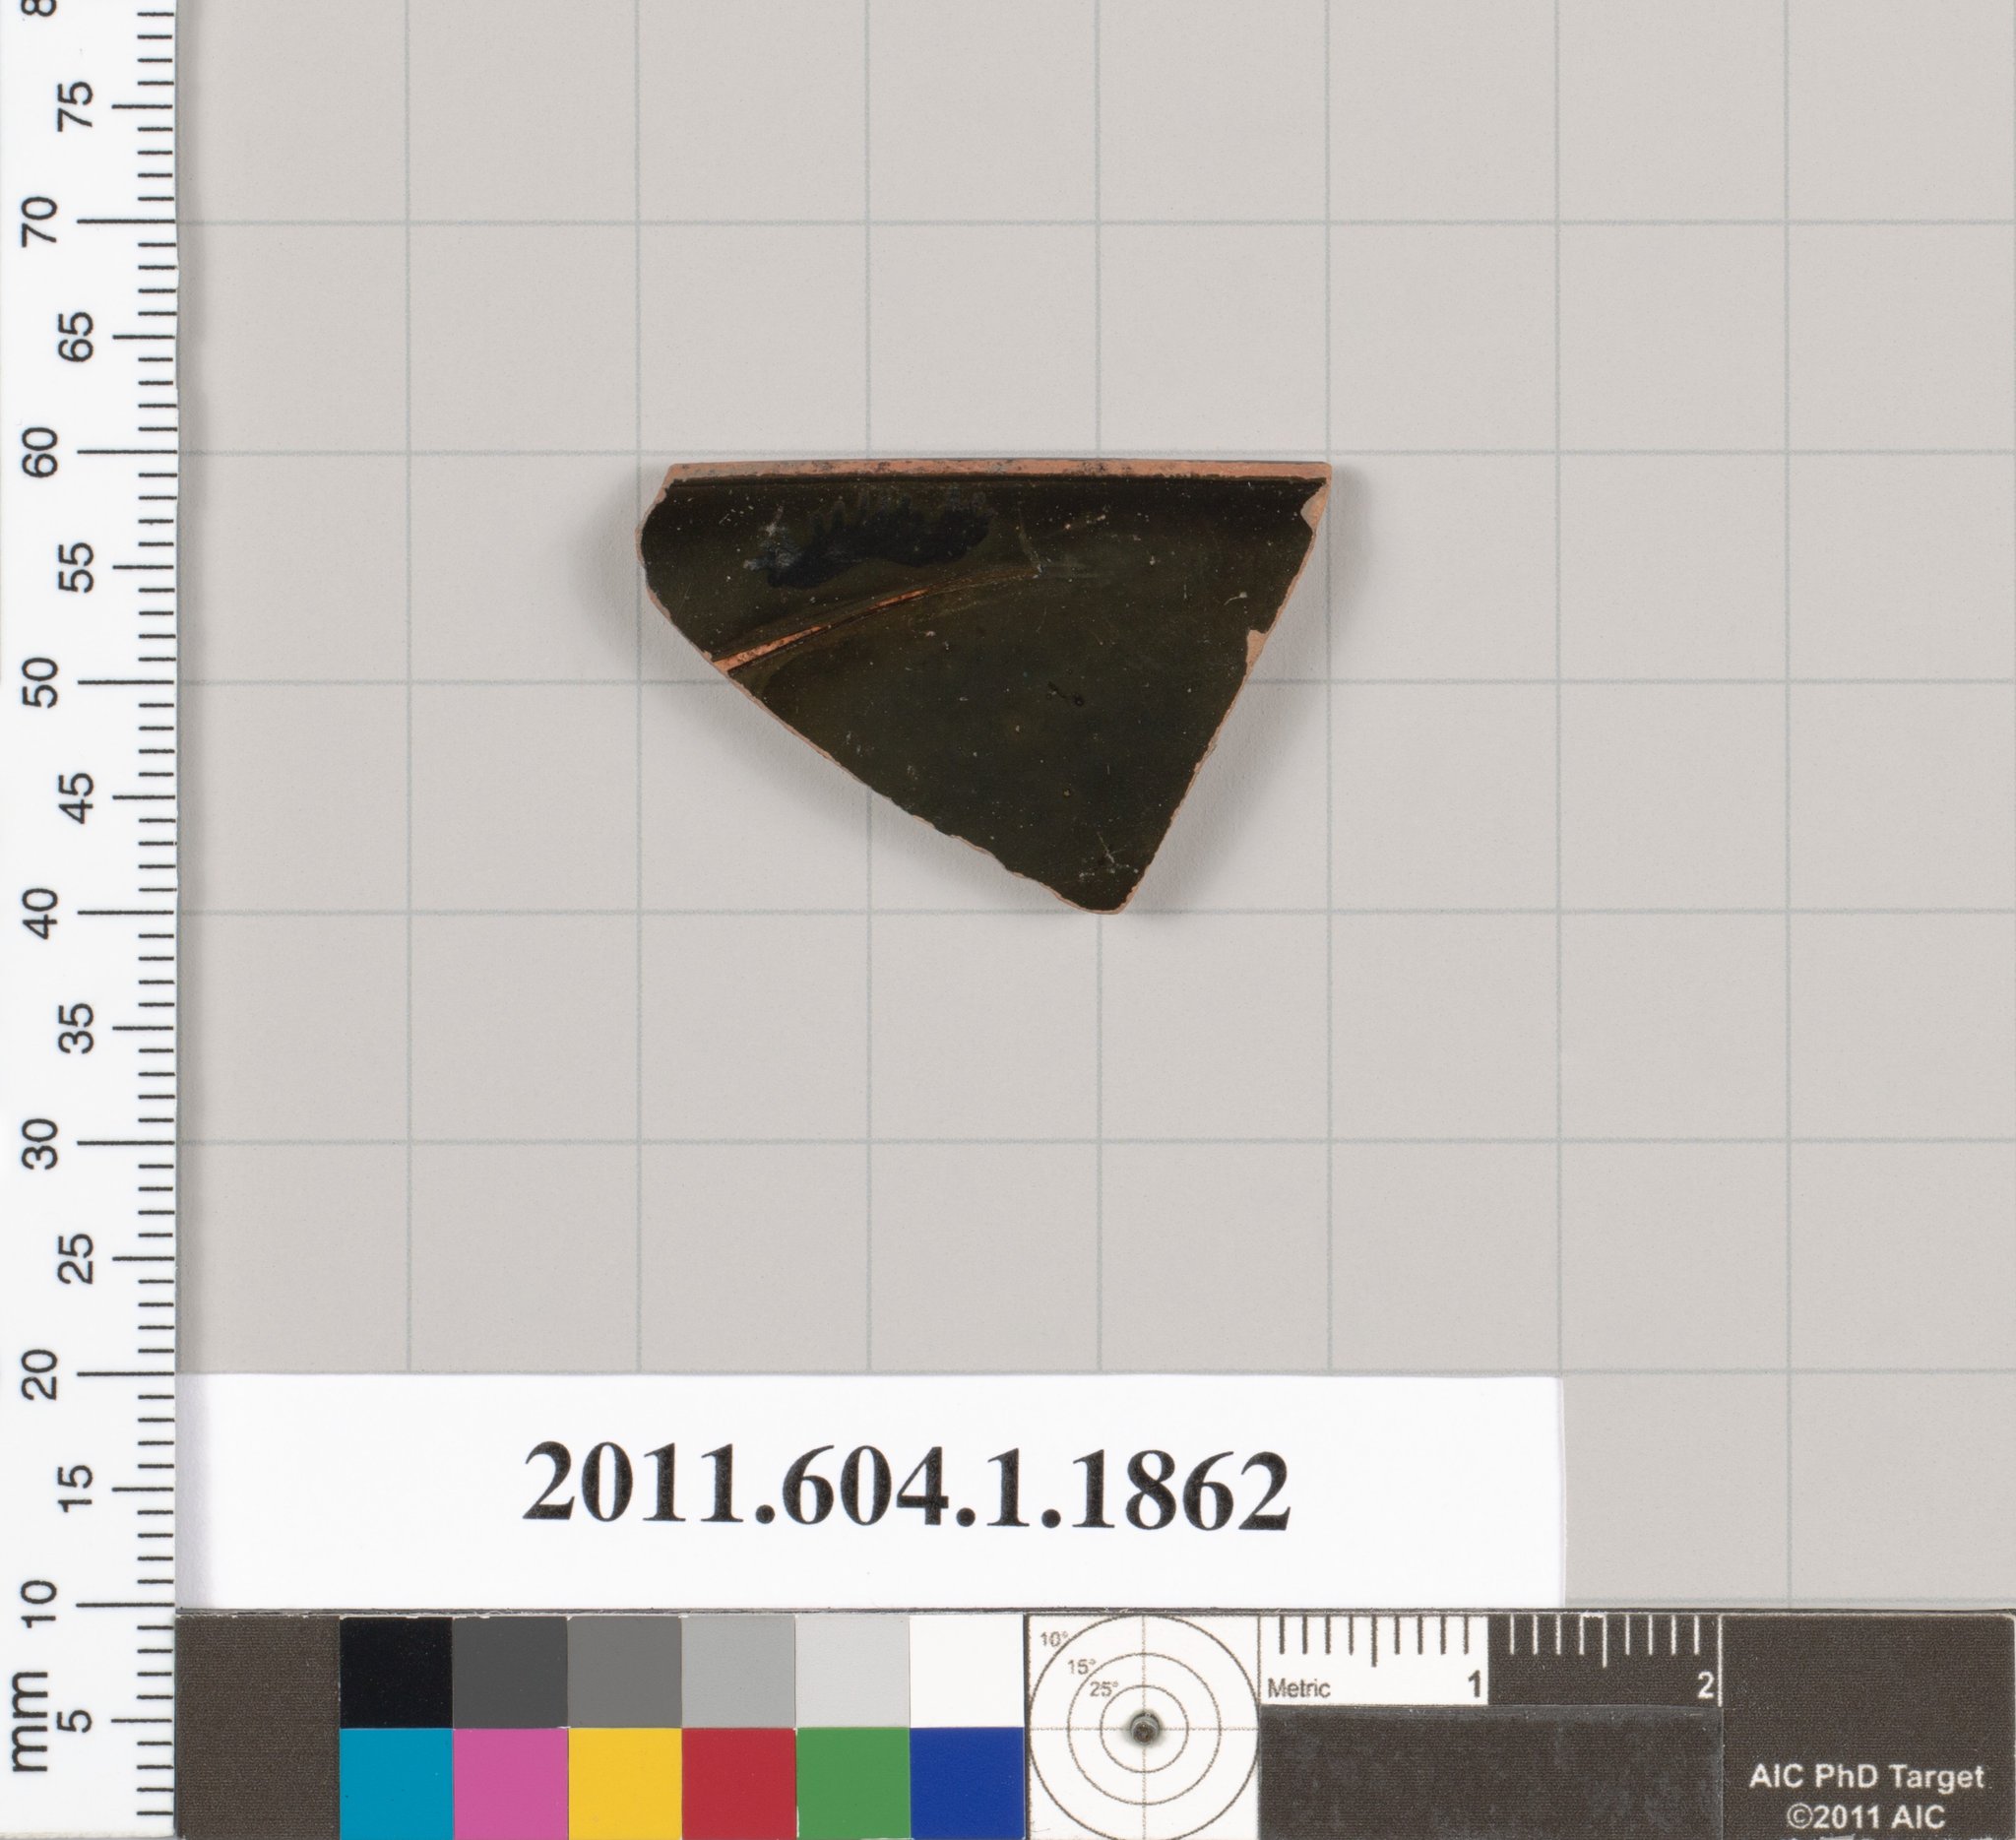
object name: kylix fragment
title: Terracotta rim fragment of a kylix (drinking cup)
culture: greek, attic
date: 500-401 BCE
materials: terracotta